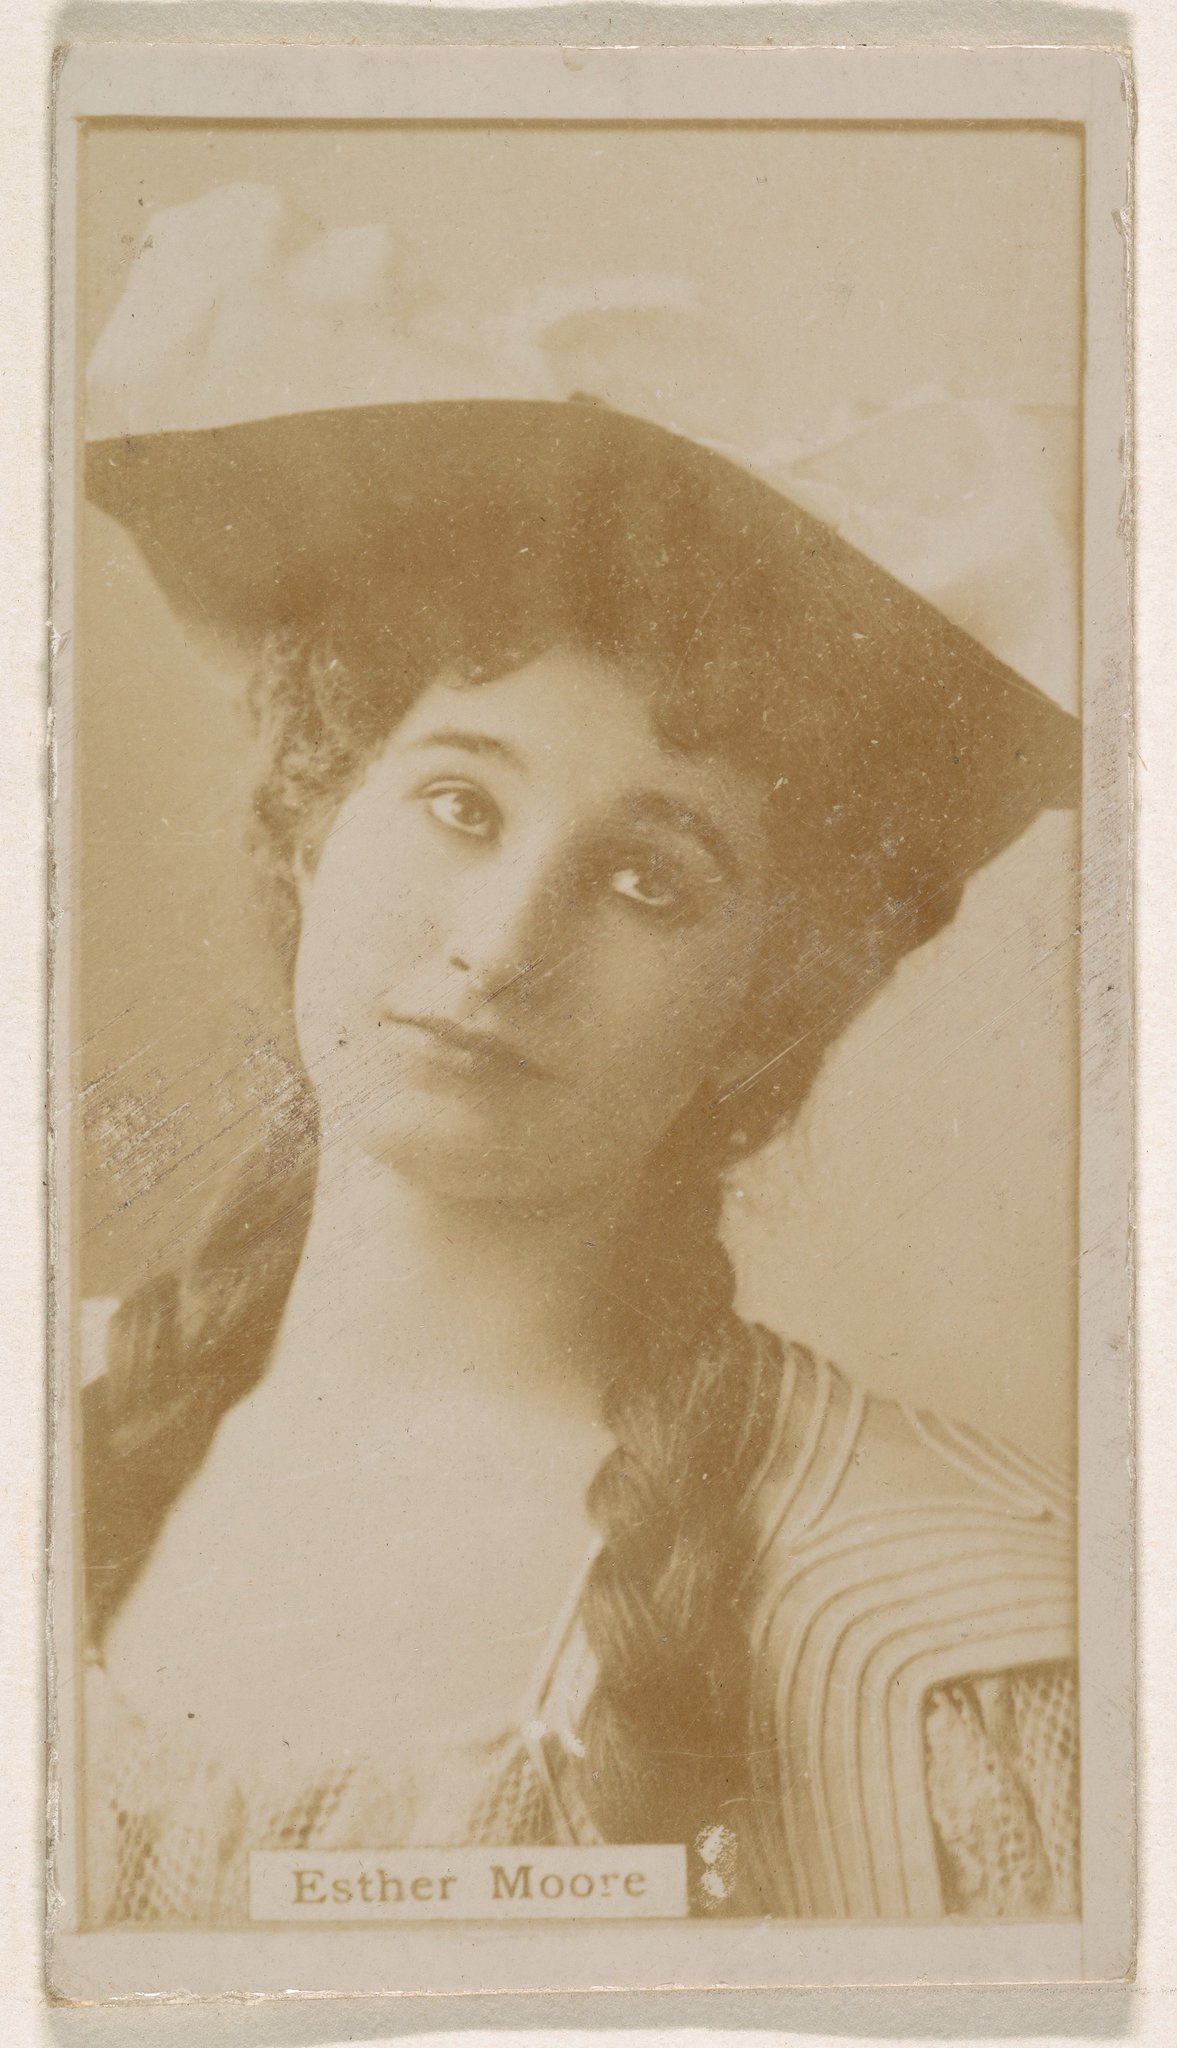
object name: photograph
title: Esther Moore, from the Actresses series (N245) issued by Kinney Brothers to promote Sweet Caporal Cigarettes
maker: kinney brothers tobacco company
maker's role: publisher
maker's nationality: american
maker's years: 1869-2011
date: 1890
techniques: albumen silver print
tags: portraits,women,actresses